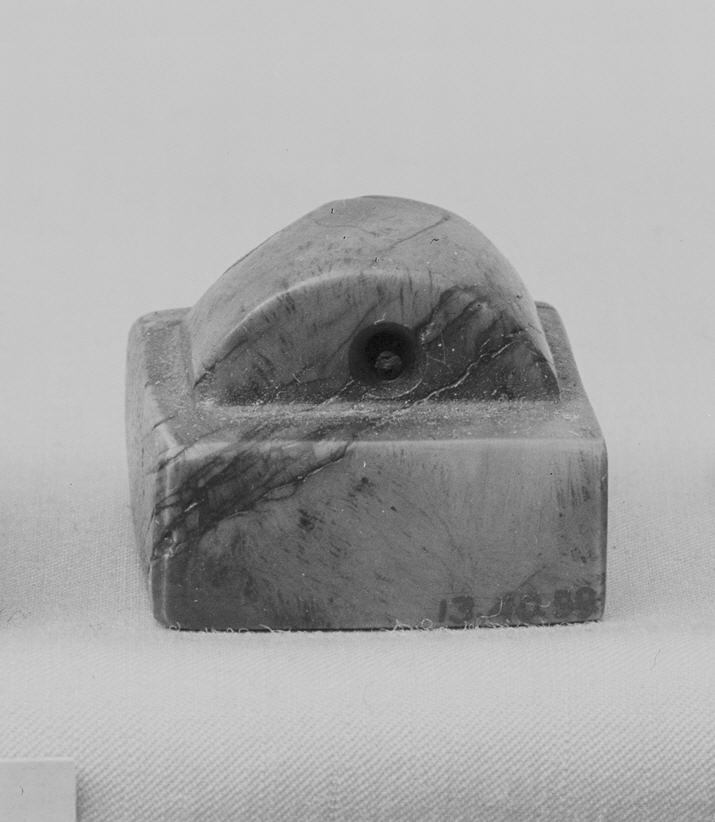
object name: seal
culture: chinese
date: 206 BCE-220 CE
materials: jade